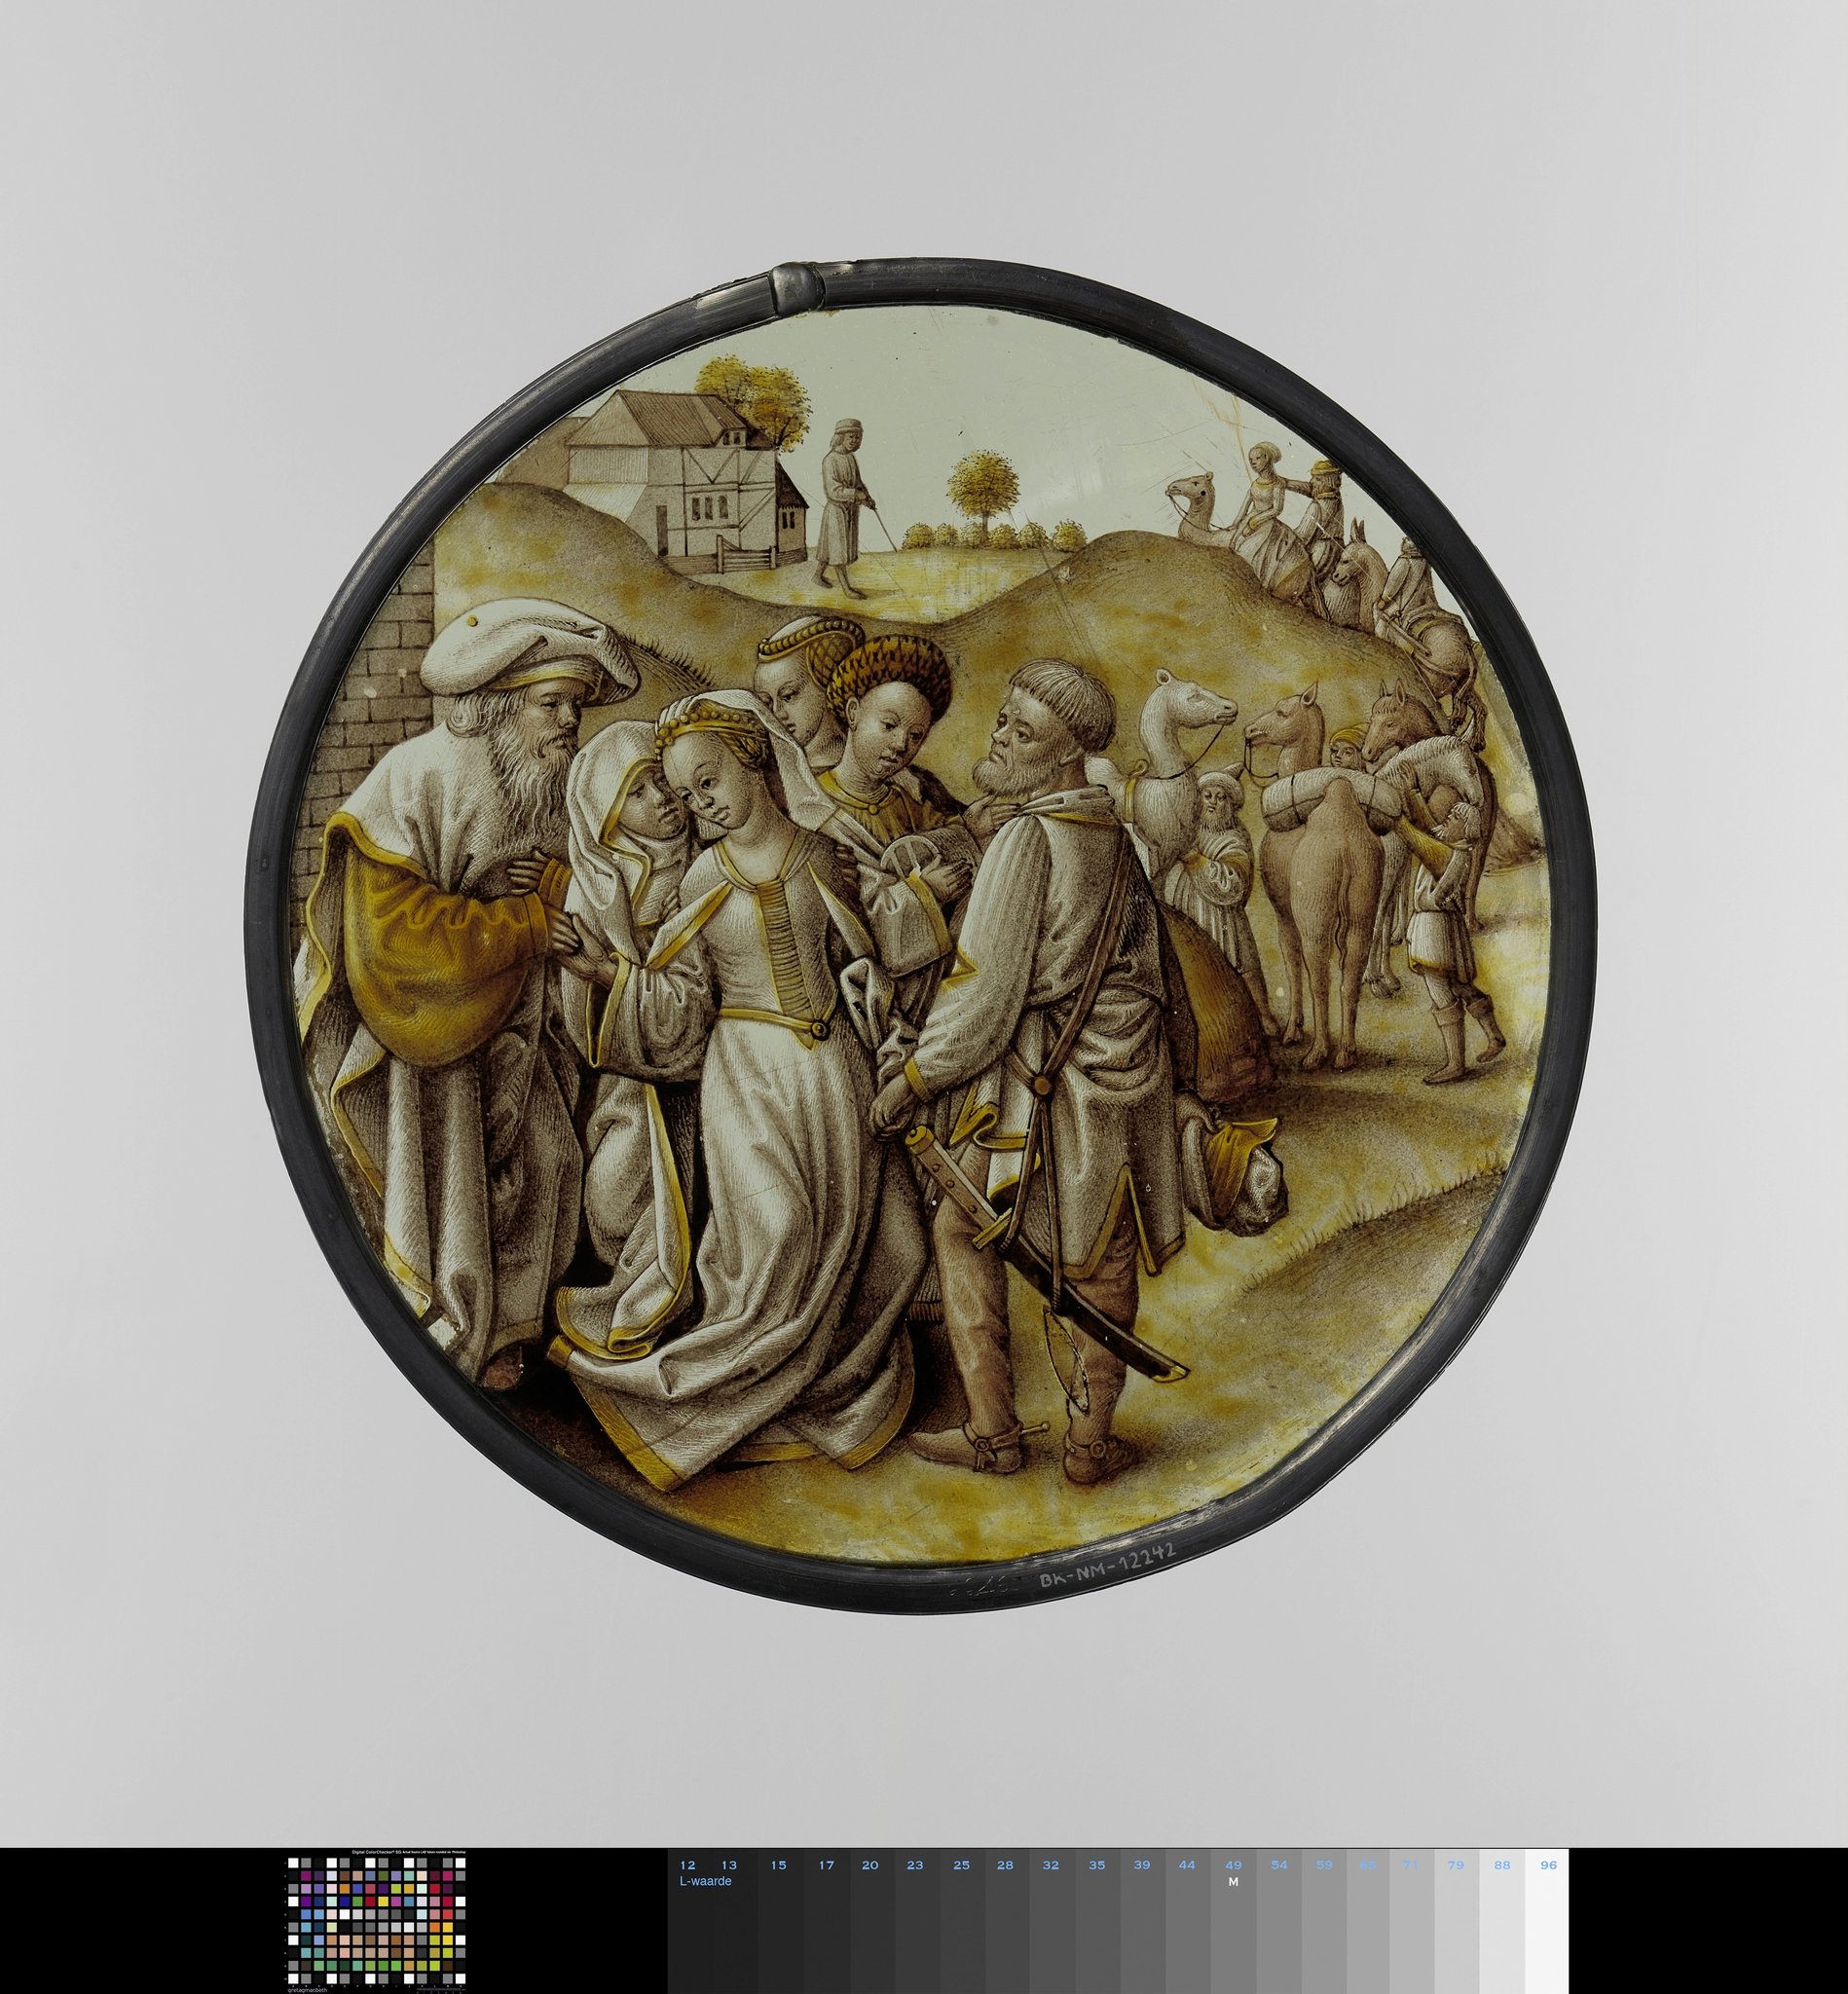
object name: light window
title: Rebekka neemt afscheid van haar ouders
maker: Anonymous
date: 1480-1500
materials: glass, lead, pigment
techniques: leading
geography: northern netherlands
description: Rebecca Taking Leave of her Family. Stained glass. Netherlands, c. 1500.